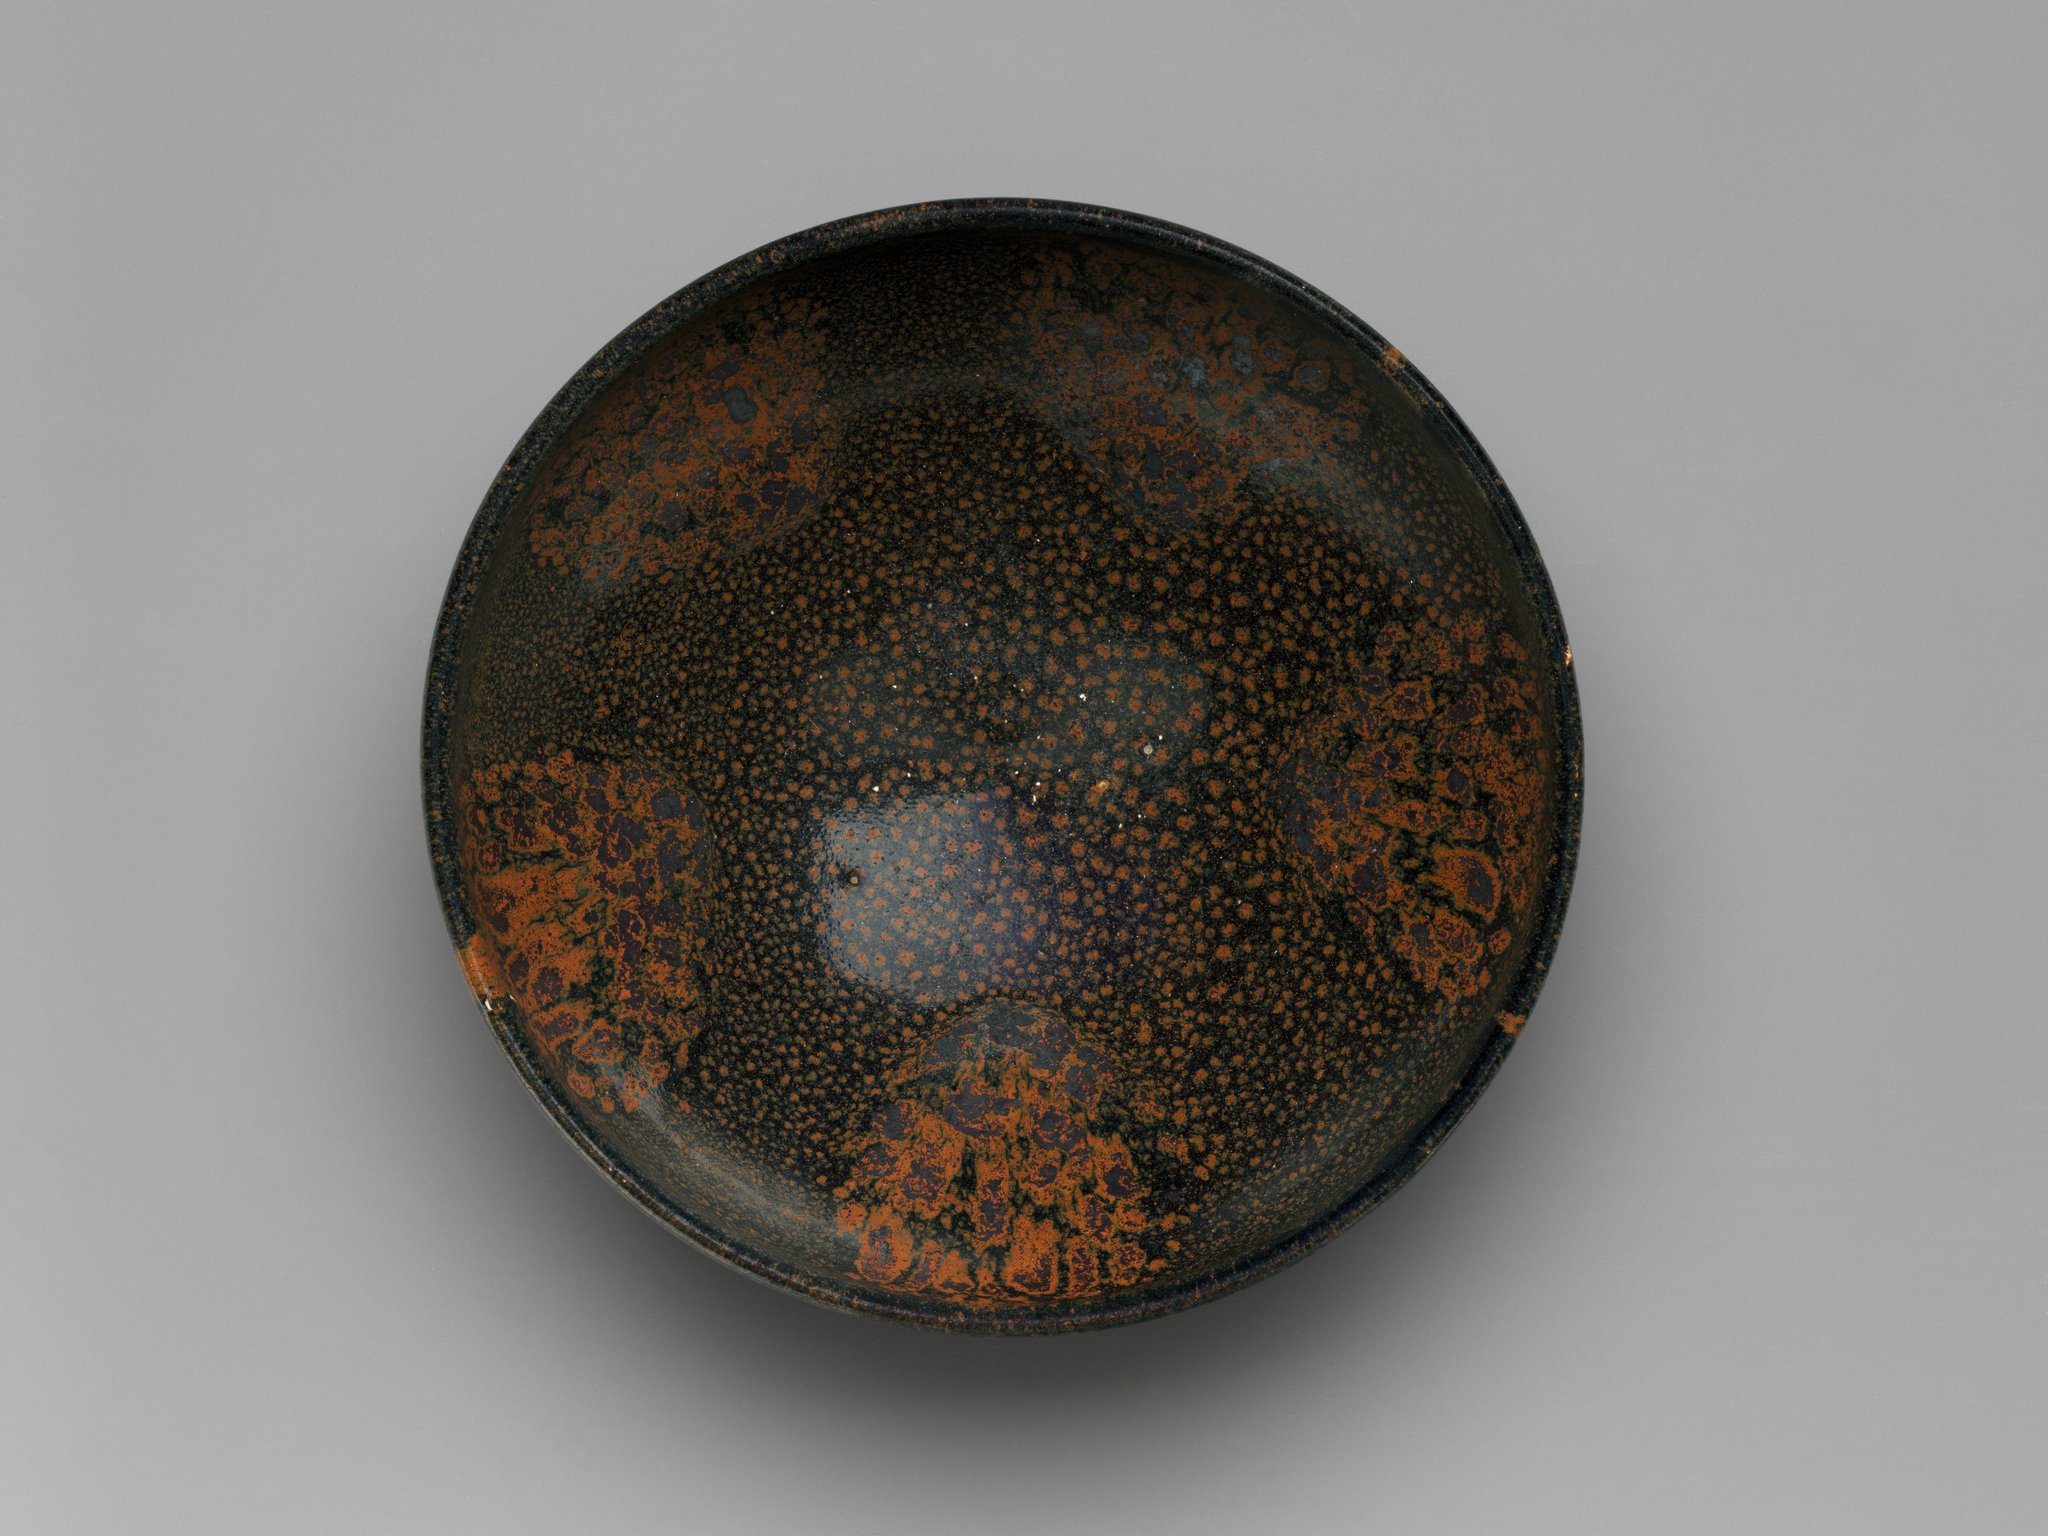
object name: bowl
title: Bowl with “Oil-Spot” Design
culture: chinese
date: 1101-1300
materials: glaze, iron, stoneware